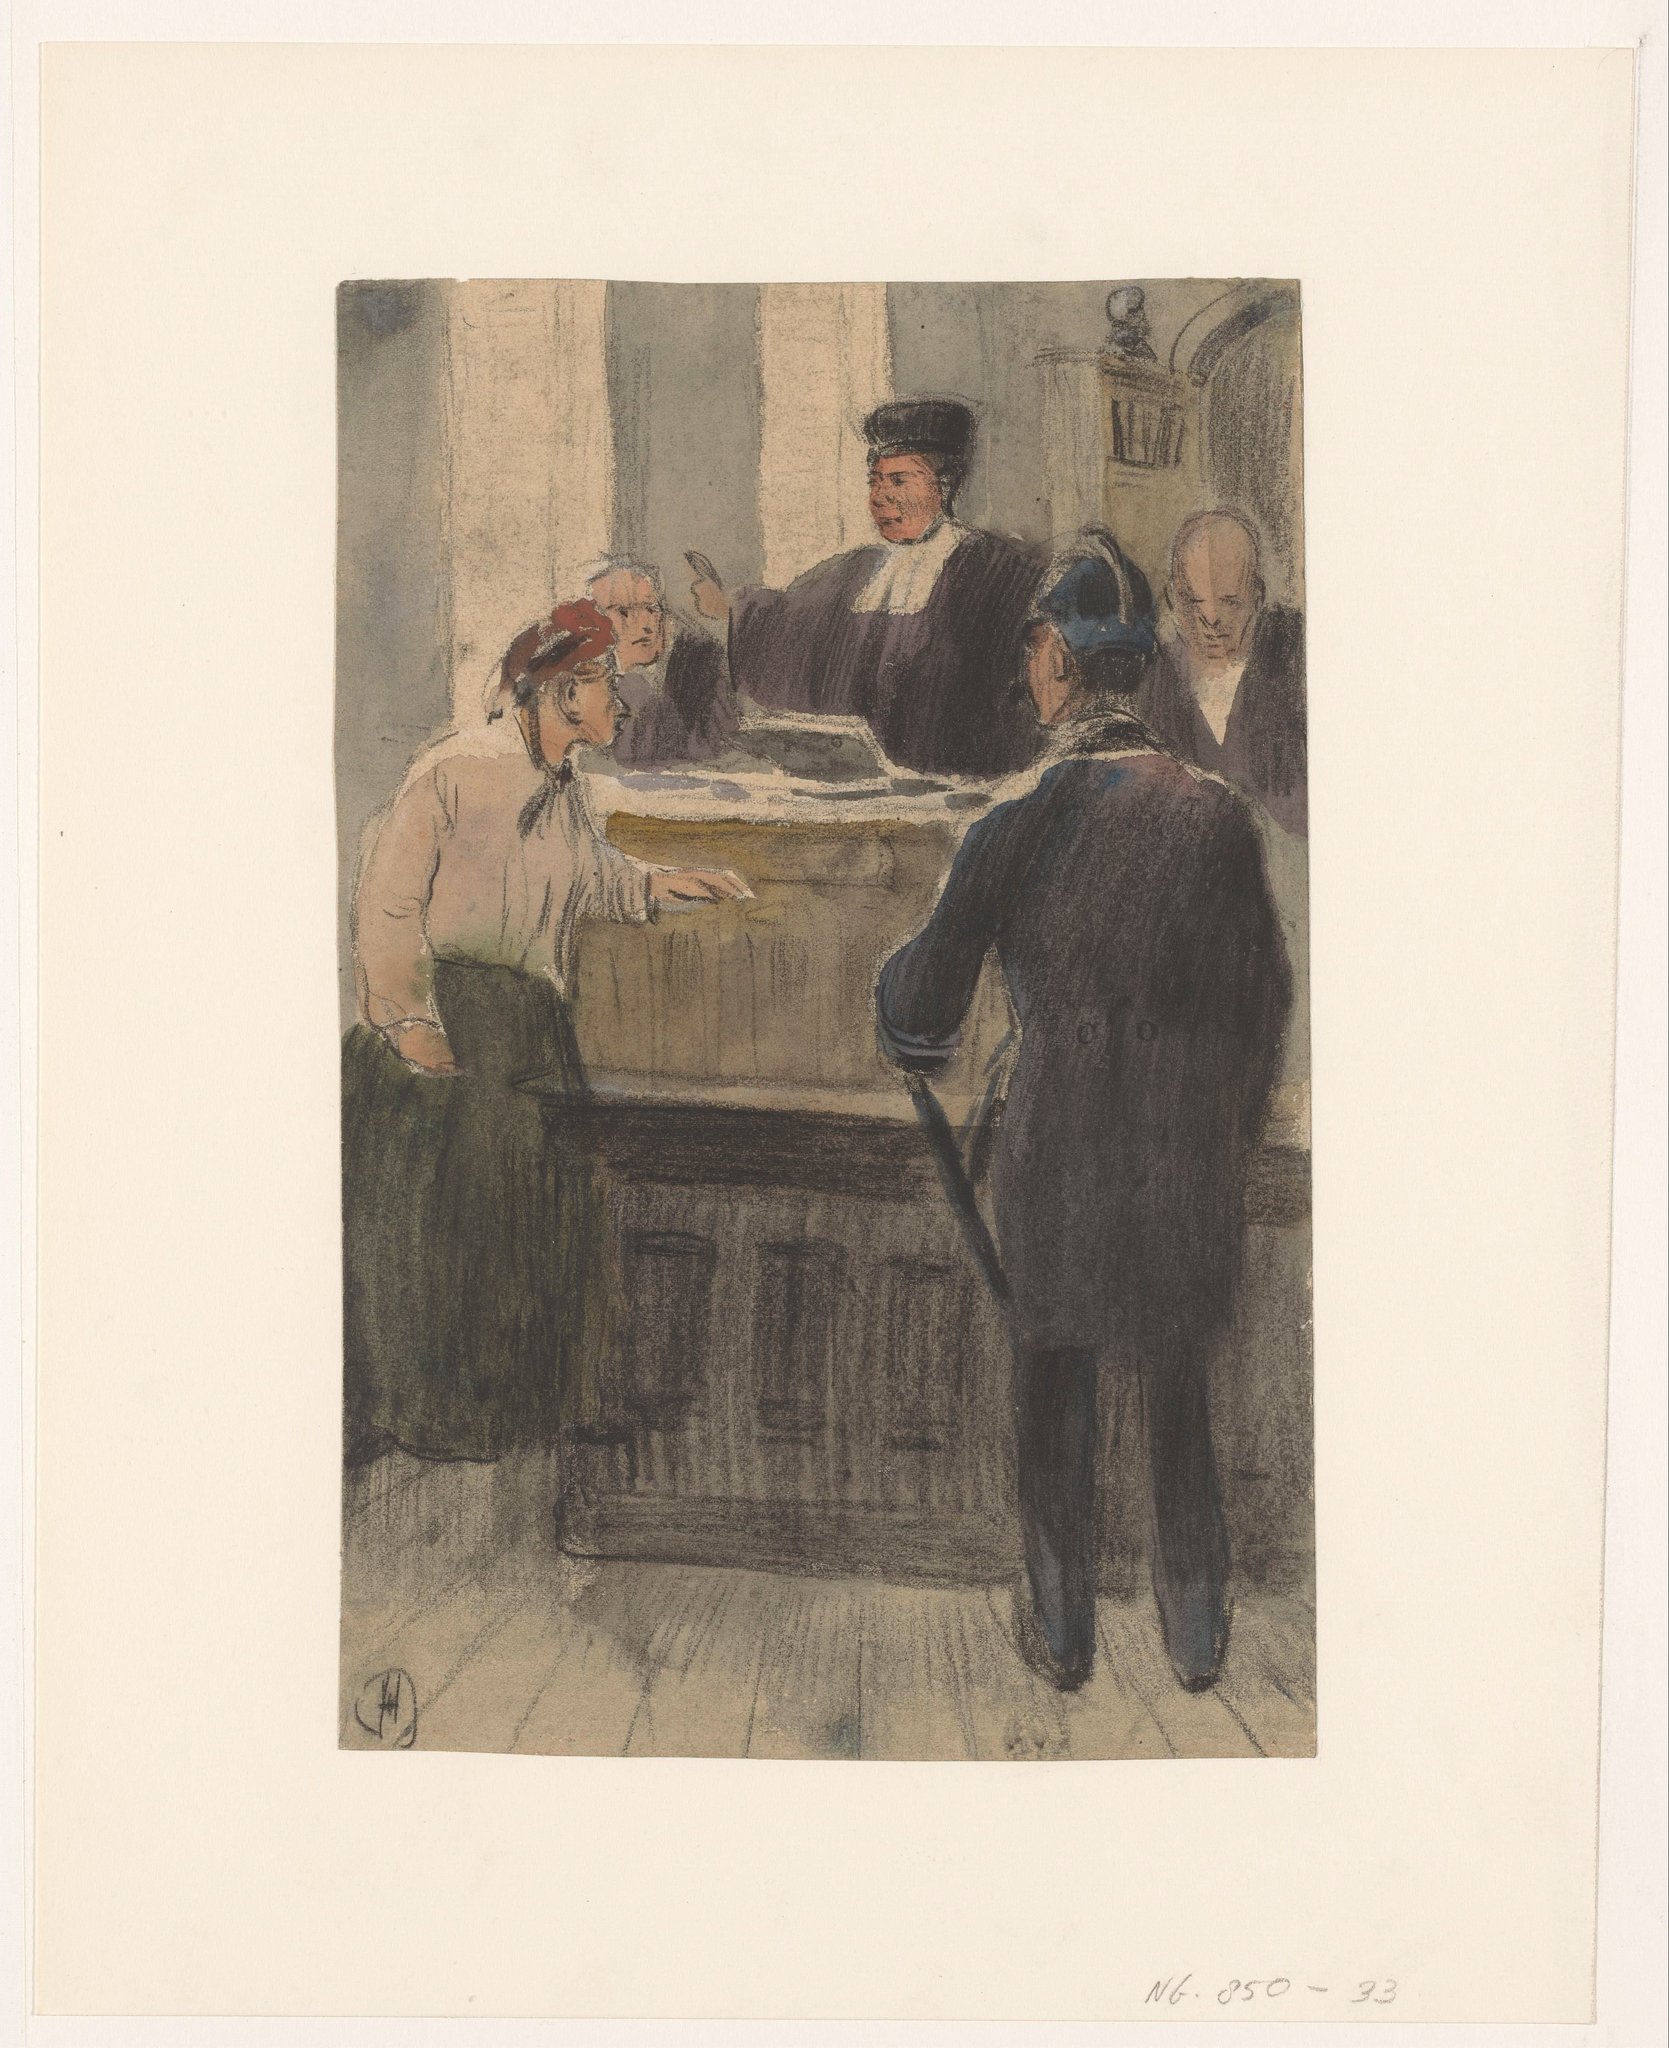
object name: drawing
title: Rechtspraak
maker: herman heijenbrock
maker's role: draughtsman, painter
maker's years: 1871-1948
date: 1881-1900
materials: chalk, paper, watercolor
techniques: brush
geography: netherlands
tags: court session (court of justice), netherlands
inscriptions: signature: ‘H’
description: Vijf figuren in een rechtszaal. V.l.n.r.: staande vrouw met rode muts, zittende ambtenaar van justitie, rechter met zwarte muts achter katheder, politieagent met helm en knuppel staand op de rug gezien, ambtenaar van justitie achter katheder.